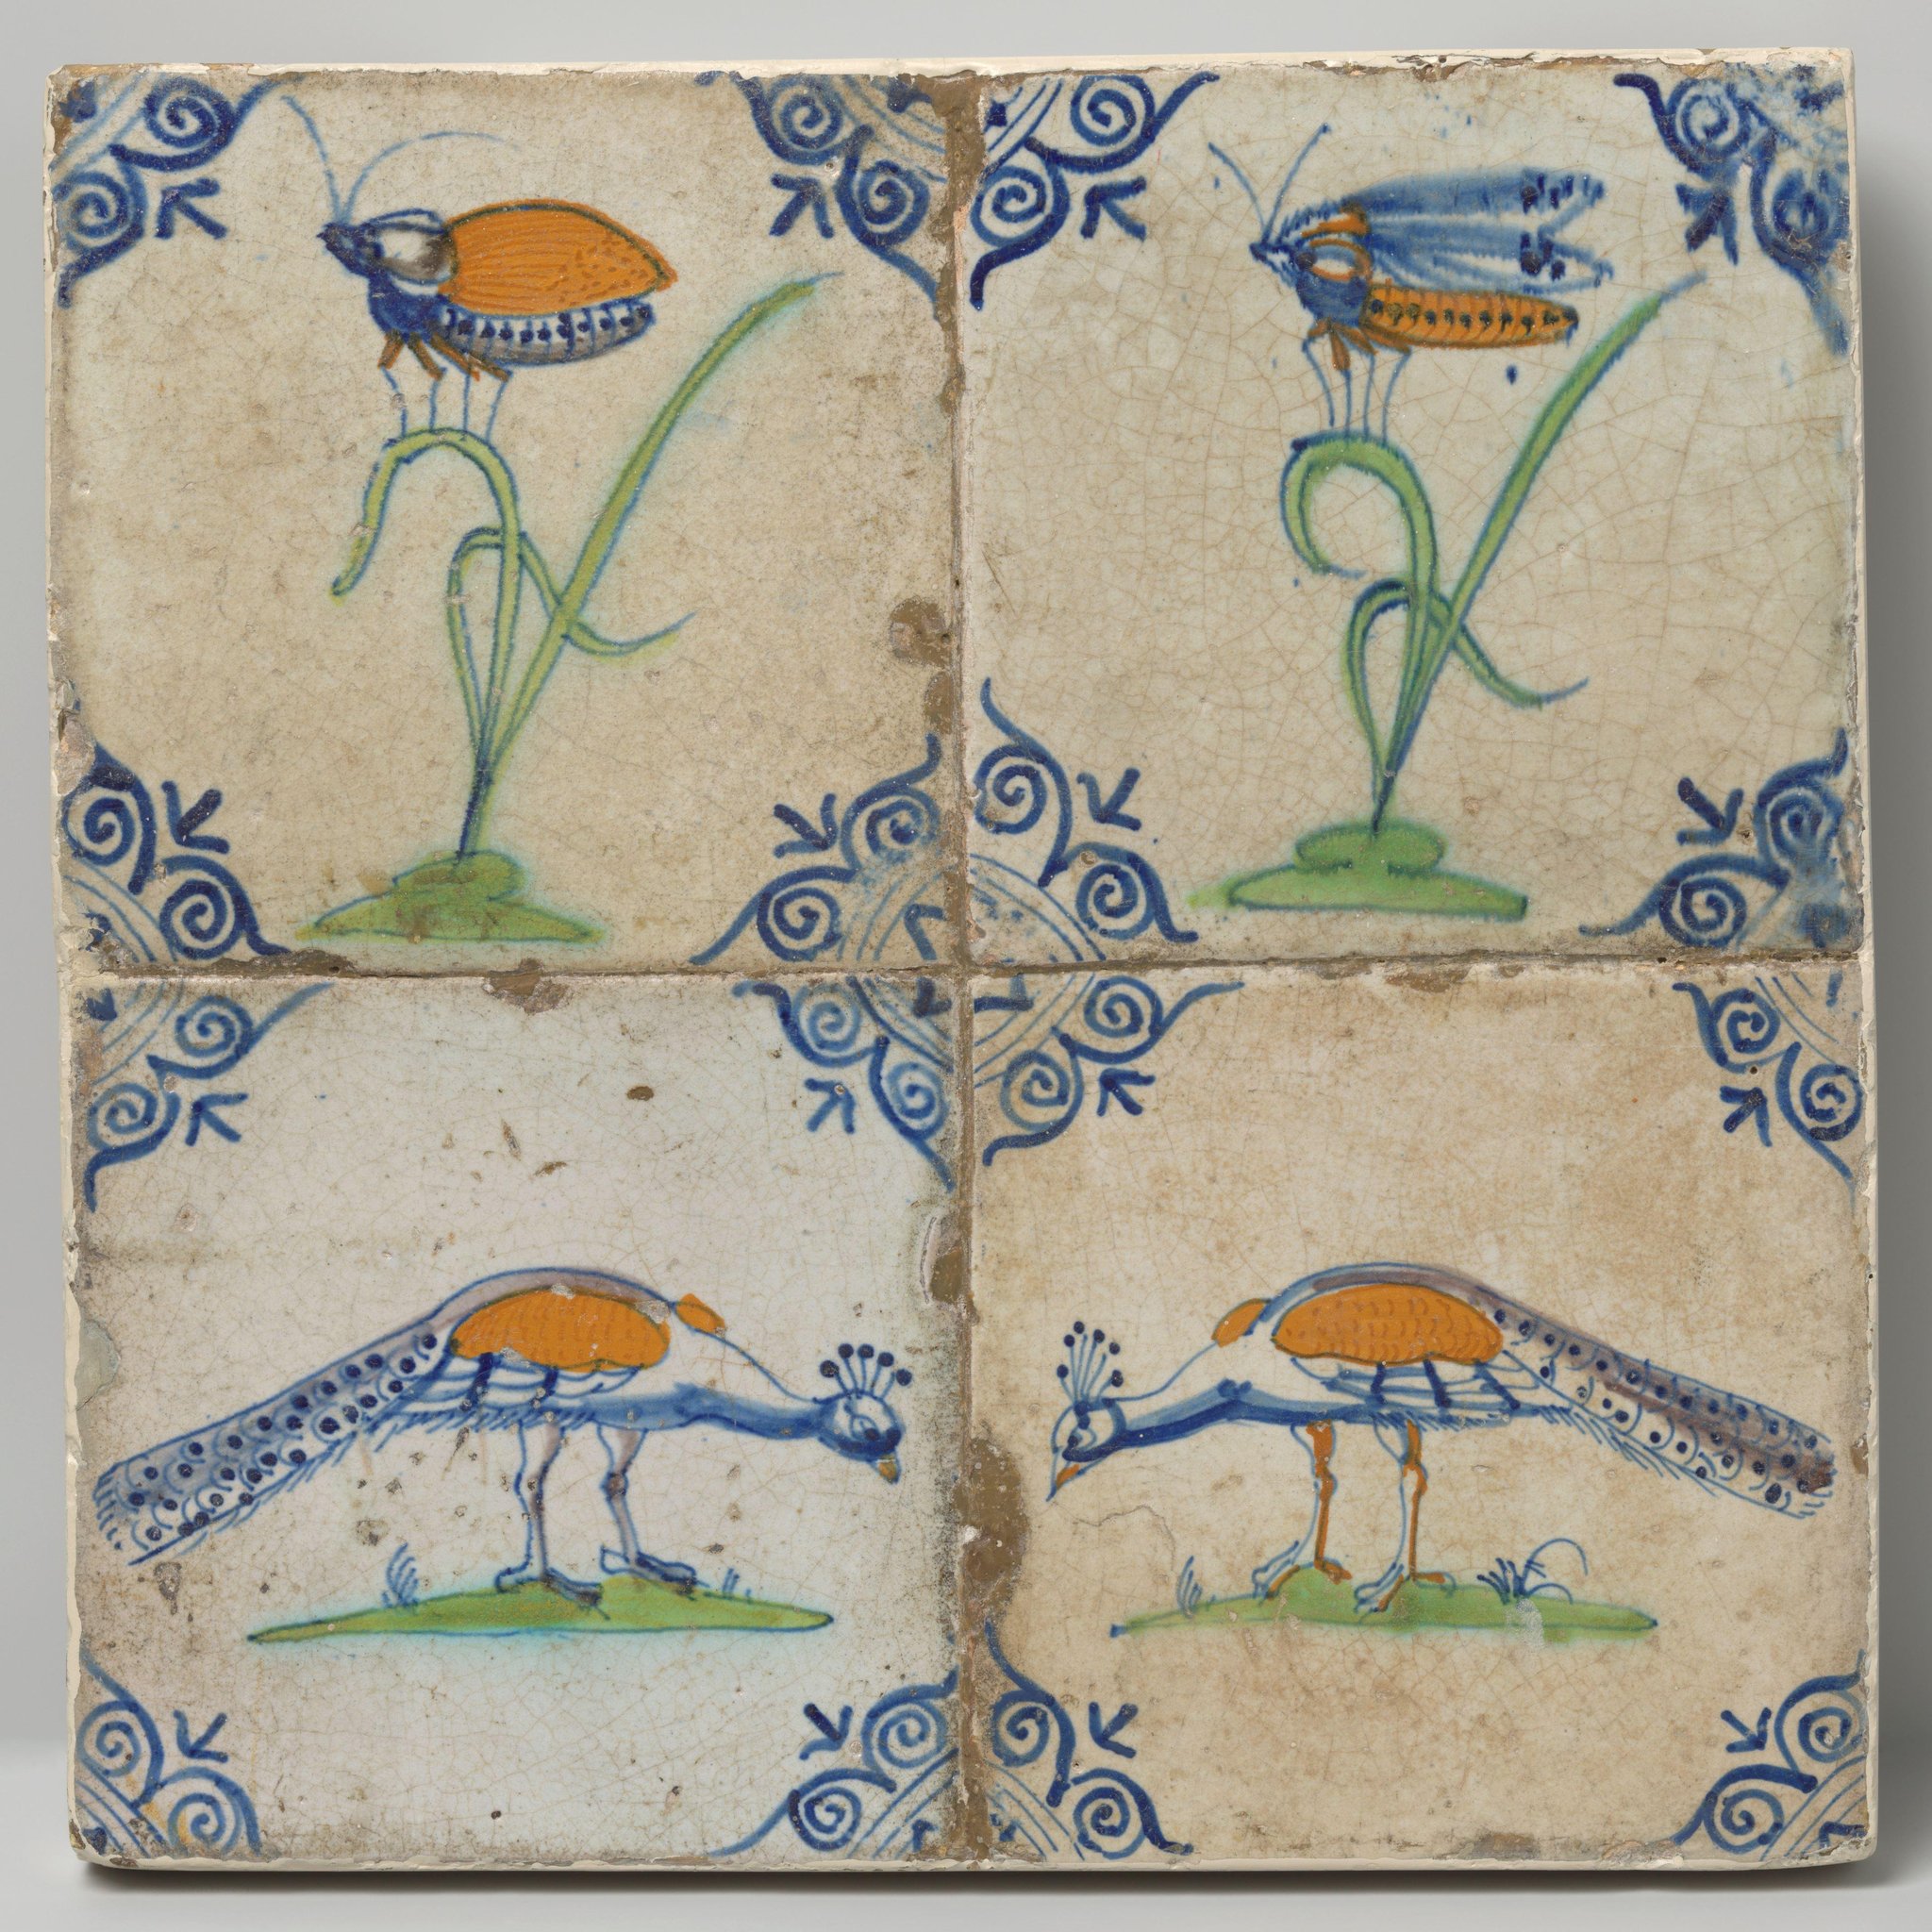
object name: tegelveld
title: Veld van vier tegels met insecten en pauwen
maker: Anonymous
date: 1640-1660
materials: earthenware, glaze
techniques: maiolica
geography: netherlands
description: Veld van vier tegels (2 x 2) elk met een veelkleurige (blauw, groen, geel, oranje en paars) insect of pauw. In de hoeken, een ossenkop.